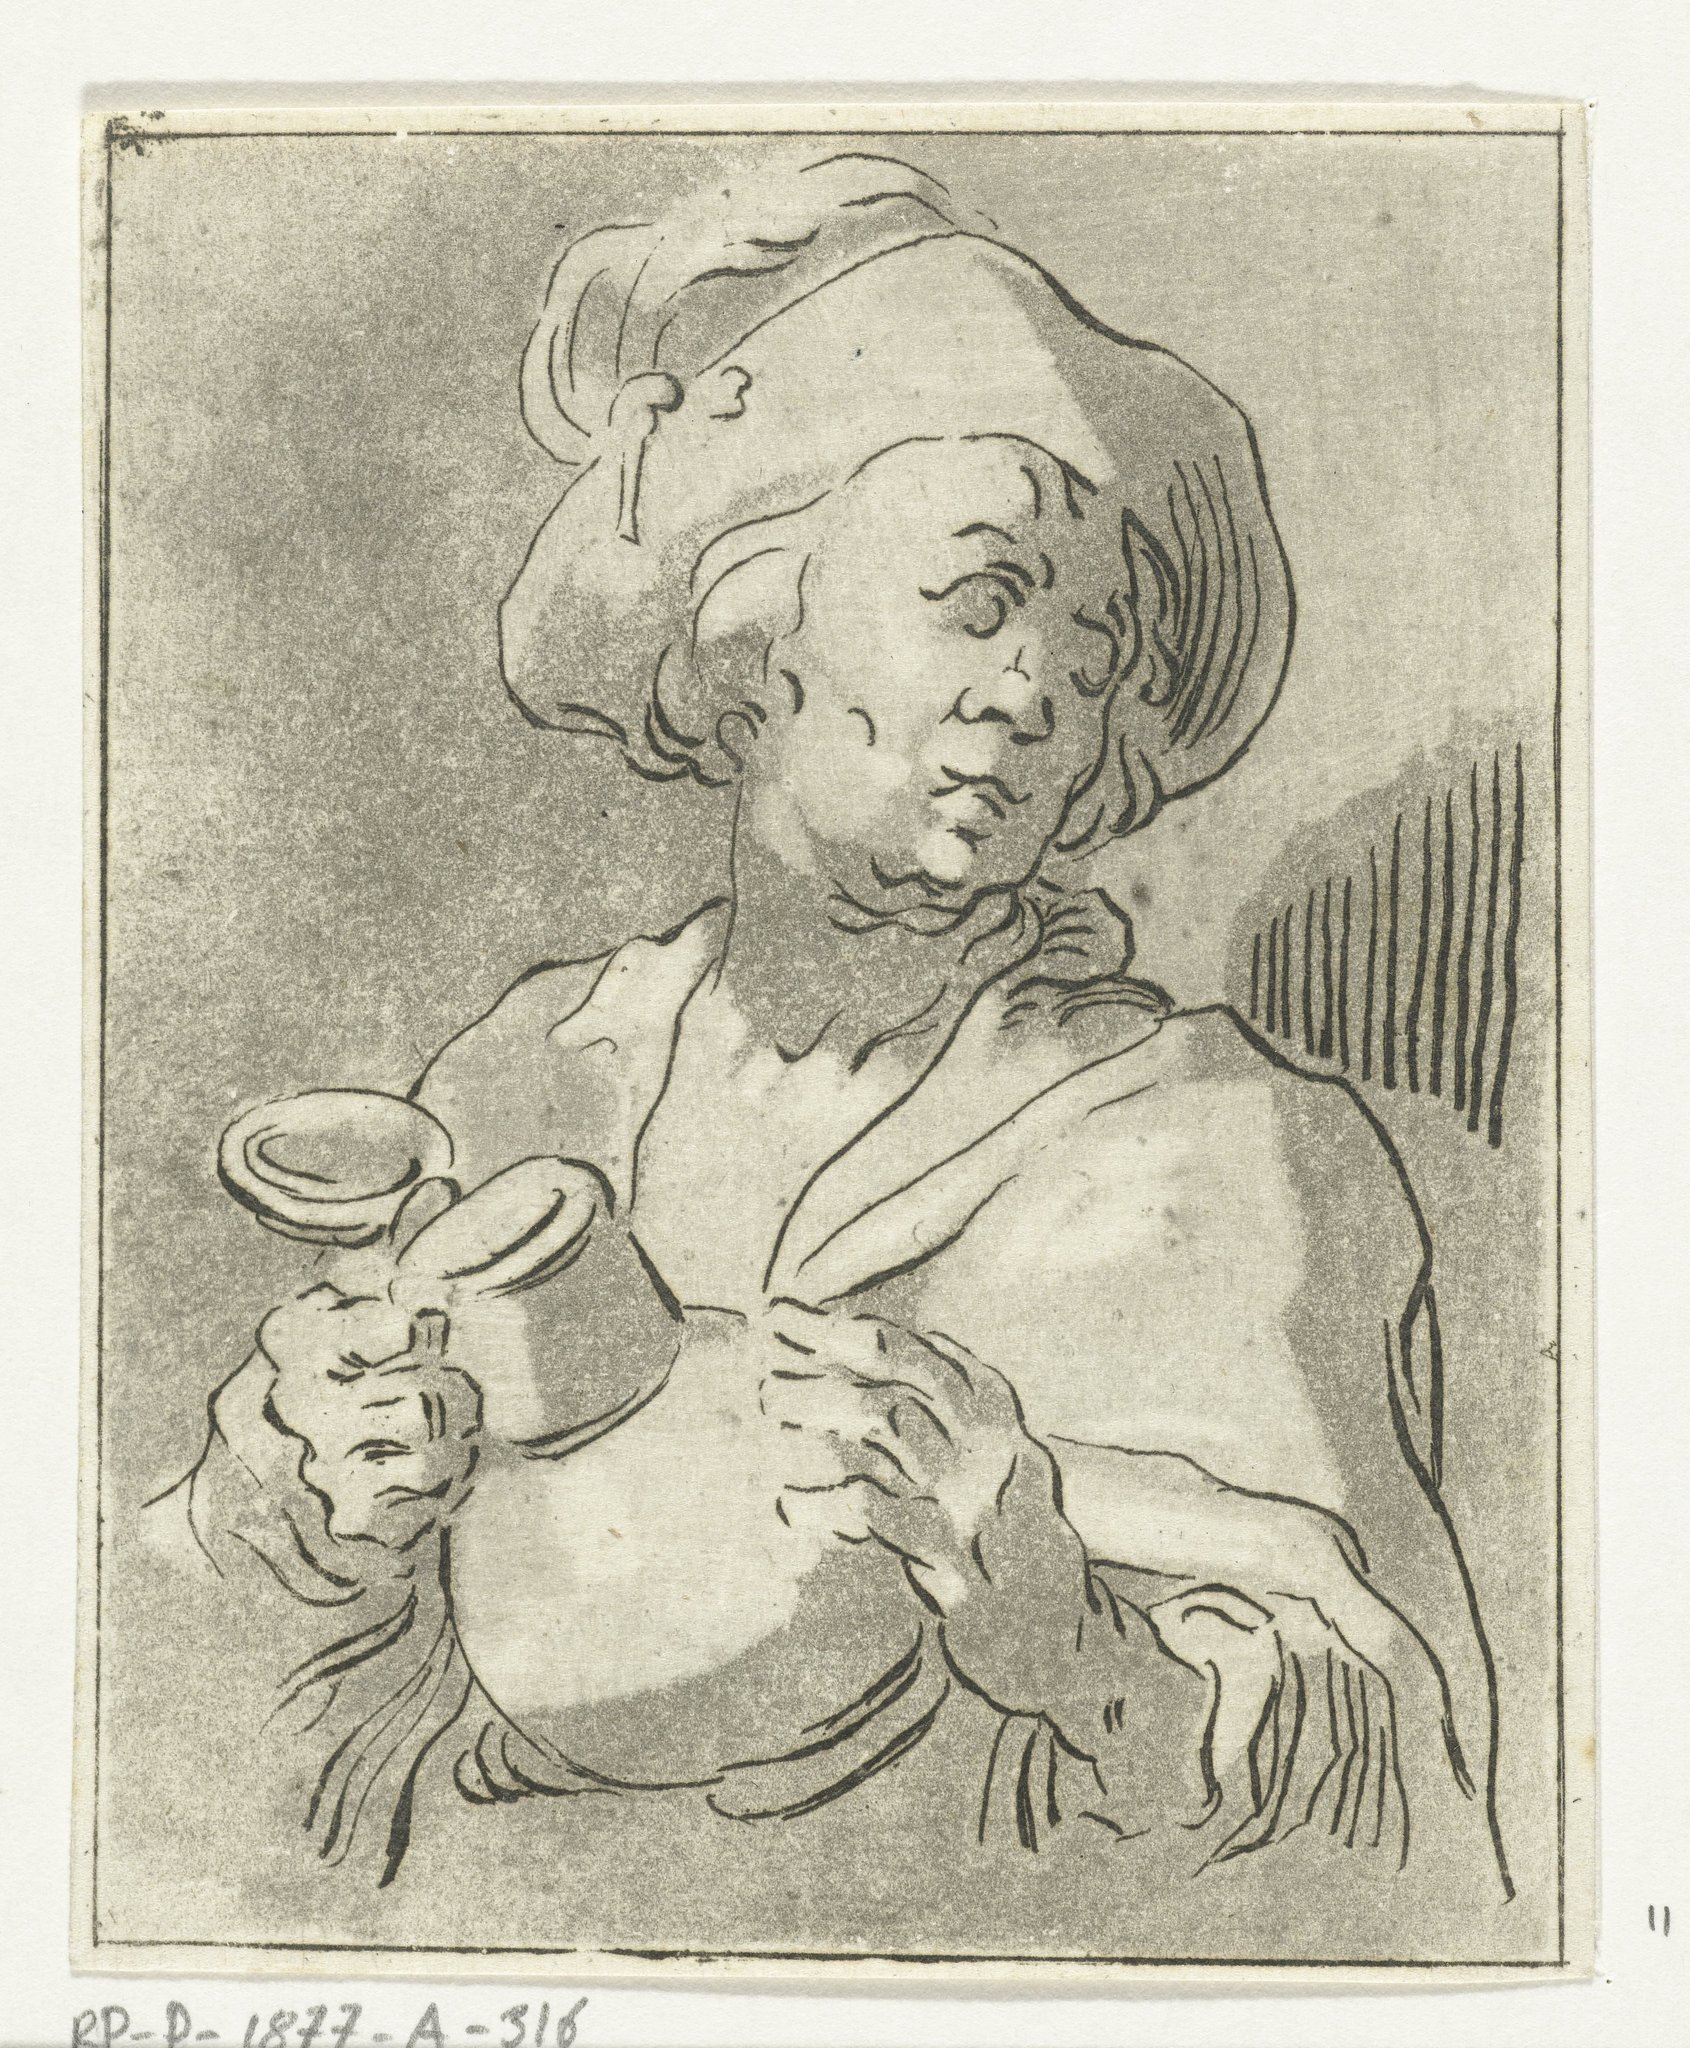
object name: print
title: Man met kruik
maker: anthonie van den bos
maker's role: draughtsman, print maker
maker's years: 1763-1838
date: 1778-1838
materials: paper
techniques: aquatint, etching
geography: netherlands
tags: jar, jug (used as drinking-vessel)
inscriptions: collector's mark: Lugt 2228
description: Een man met een pluimhoed en een kruik met deksel in zijn hand.